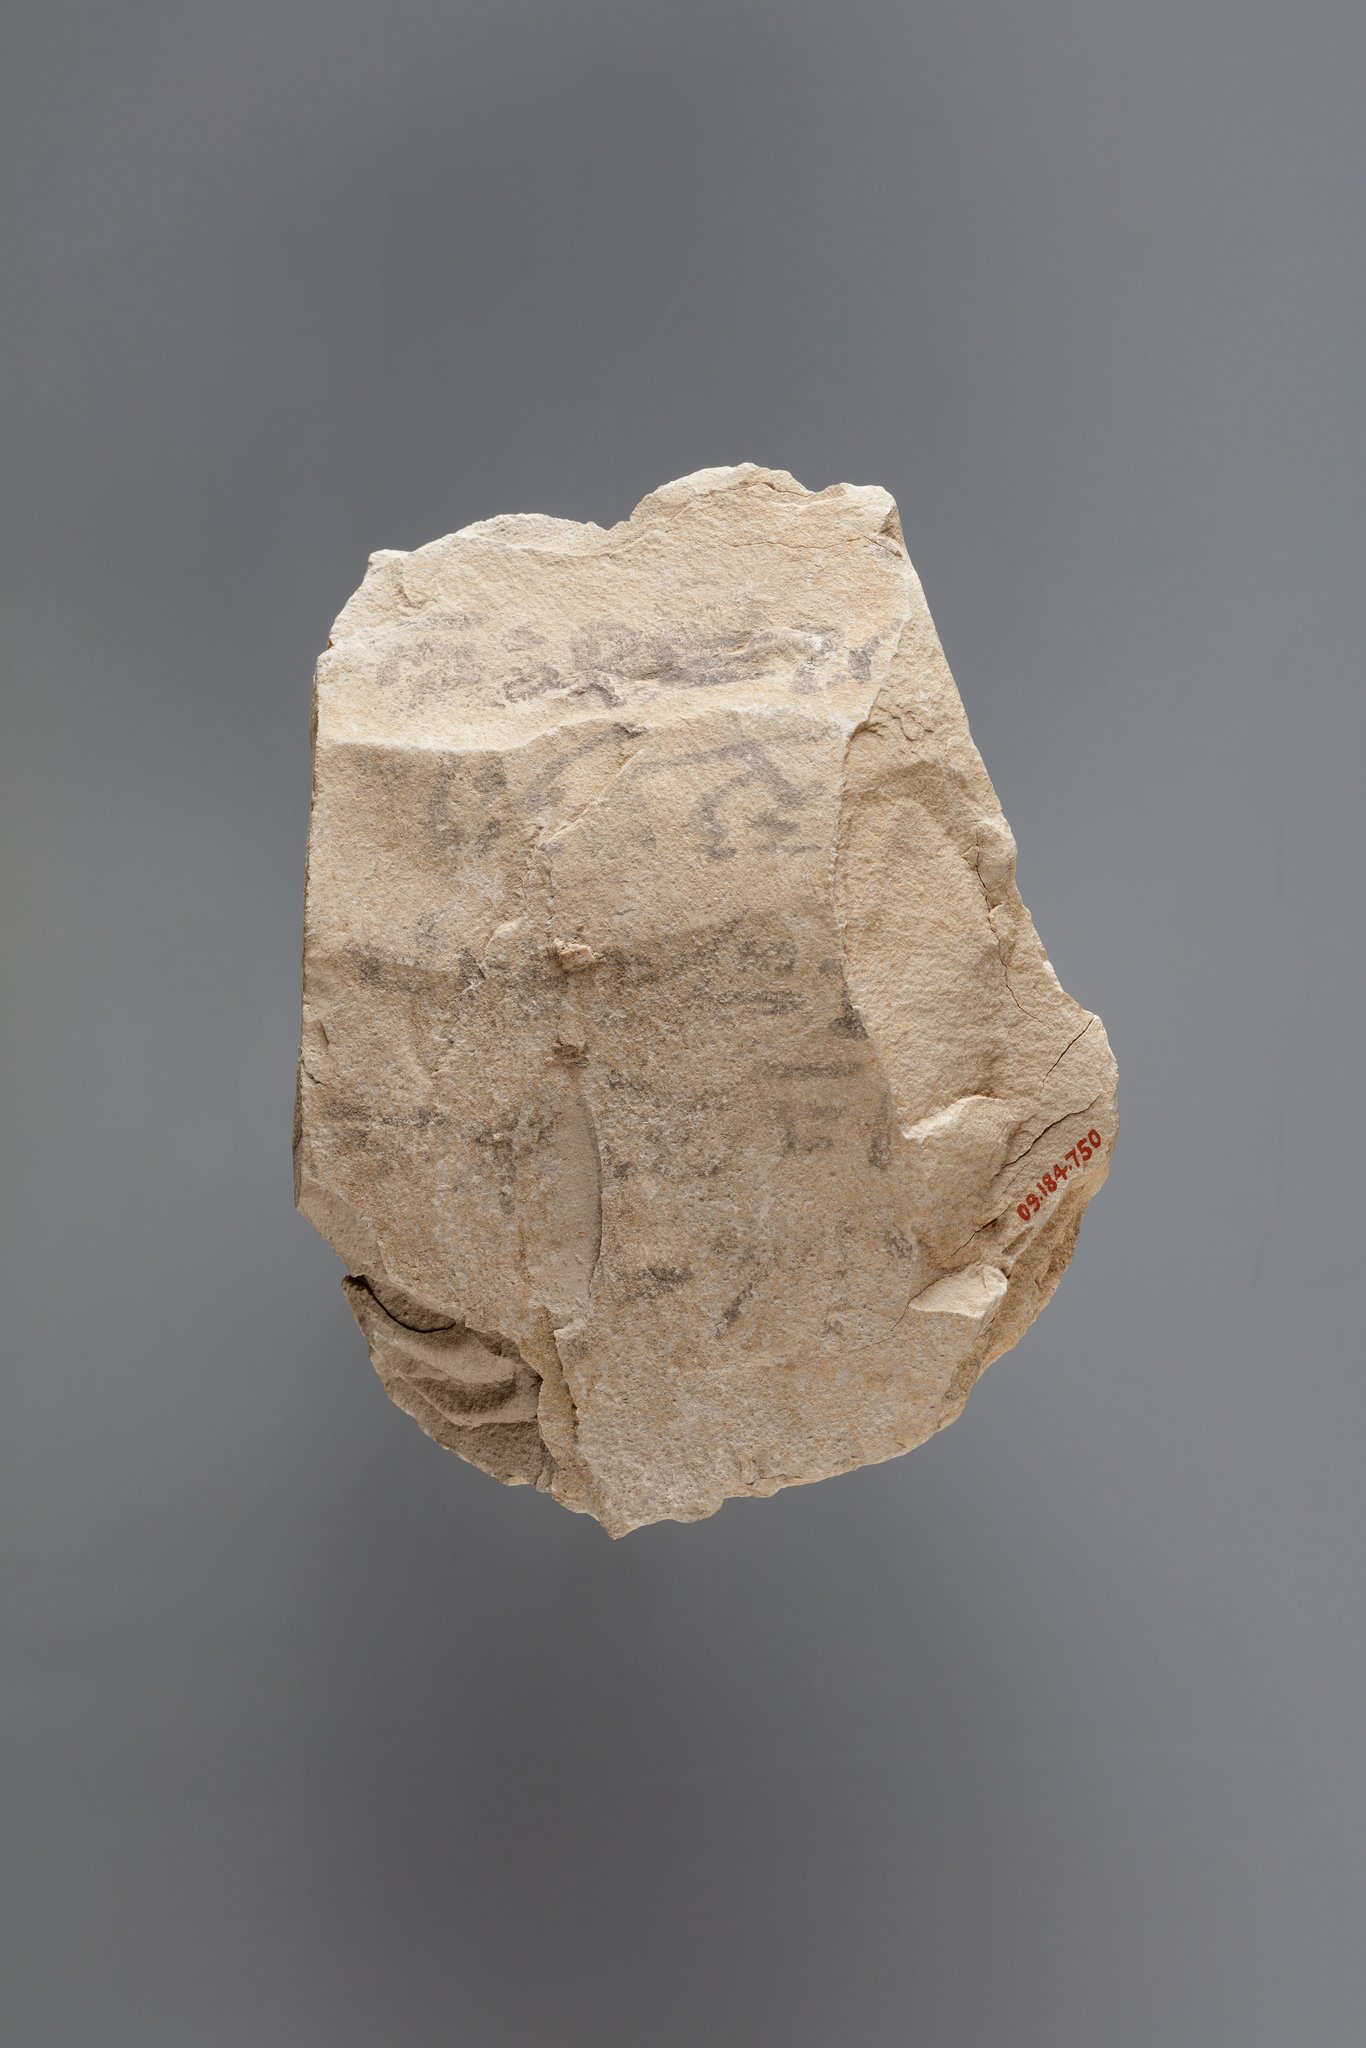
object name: ostracon, hieratic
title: Hieratic ostracon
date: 1295-1070 BCE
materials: ink, limestone, paint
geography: egypt